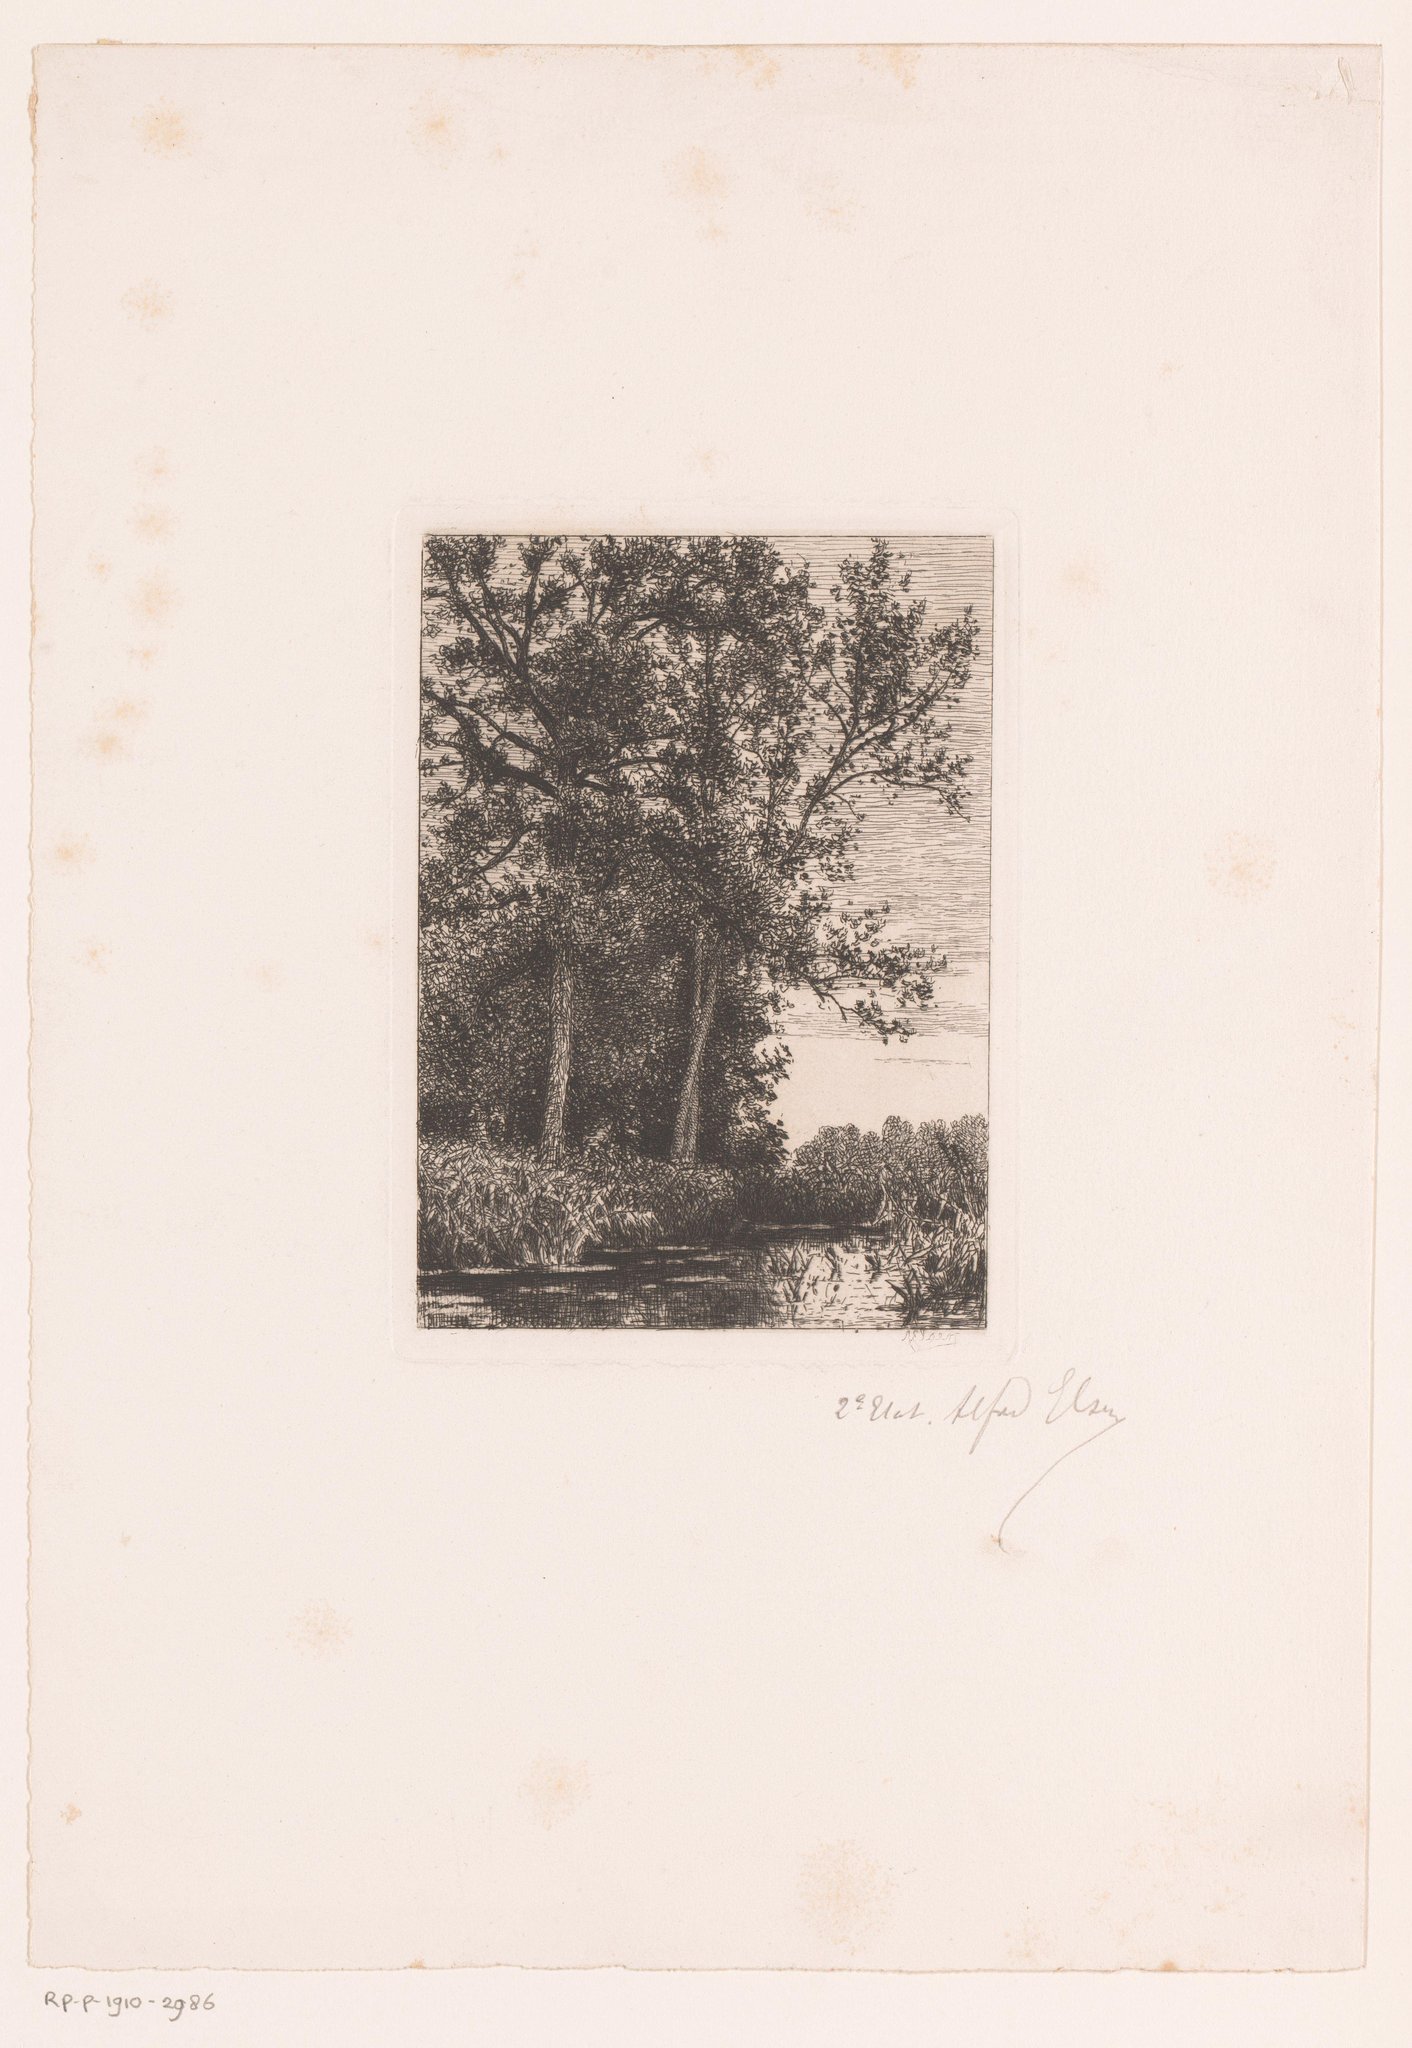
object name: print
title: Landschap met bomen aan het water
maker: alfred elsen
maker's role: painter, print maker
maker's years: 1850-1914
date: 1860-1910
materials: paper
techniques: etching, intaglio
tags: lake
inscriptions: inscription: ‘2e Etat’, collector's mark: Lugt 2228